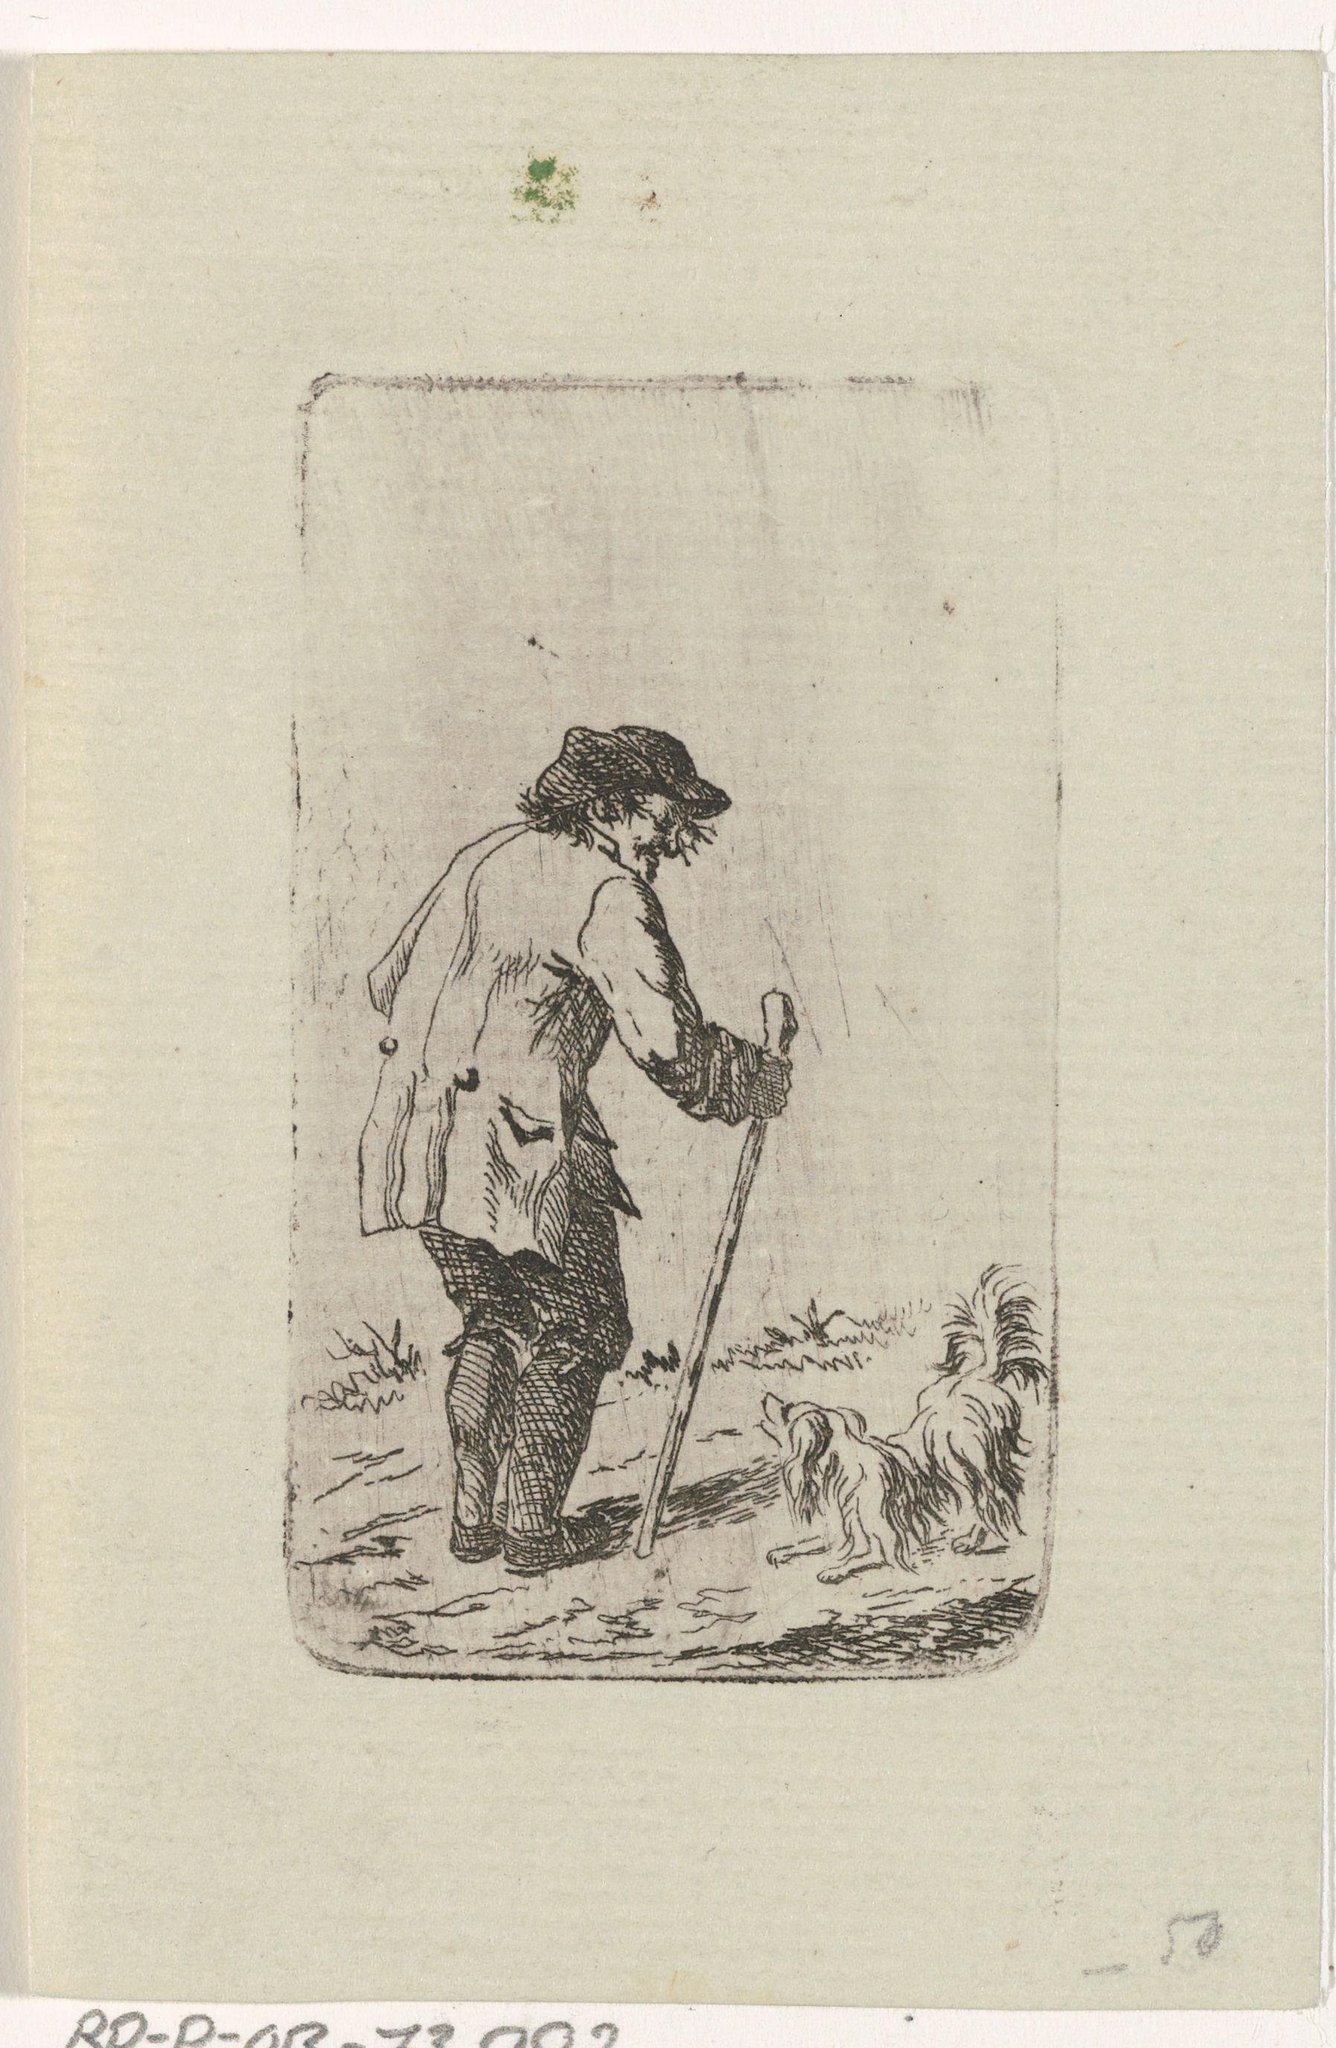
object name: print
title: Oude man steunend op een stok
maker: johannes bisschop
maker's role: print maker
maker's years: 1774-1837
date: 1784-1837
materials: paper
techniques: etching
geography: the hague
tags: old man (+ back view), dog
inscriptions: collector's mark: Lugt 2228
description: Een oude man steunend op een stok op de rug gezien. Naast hem een hond.